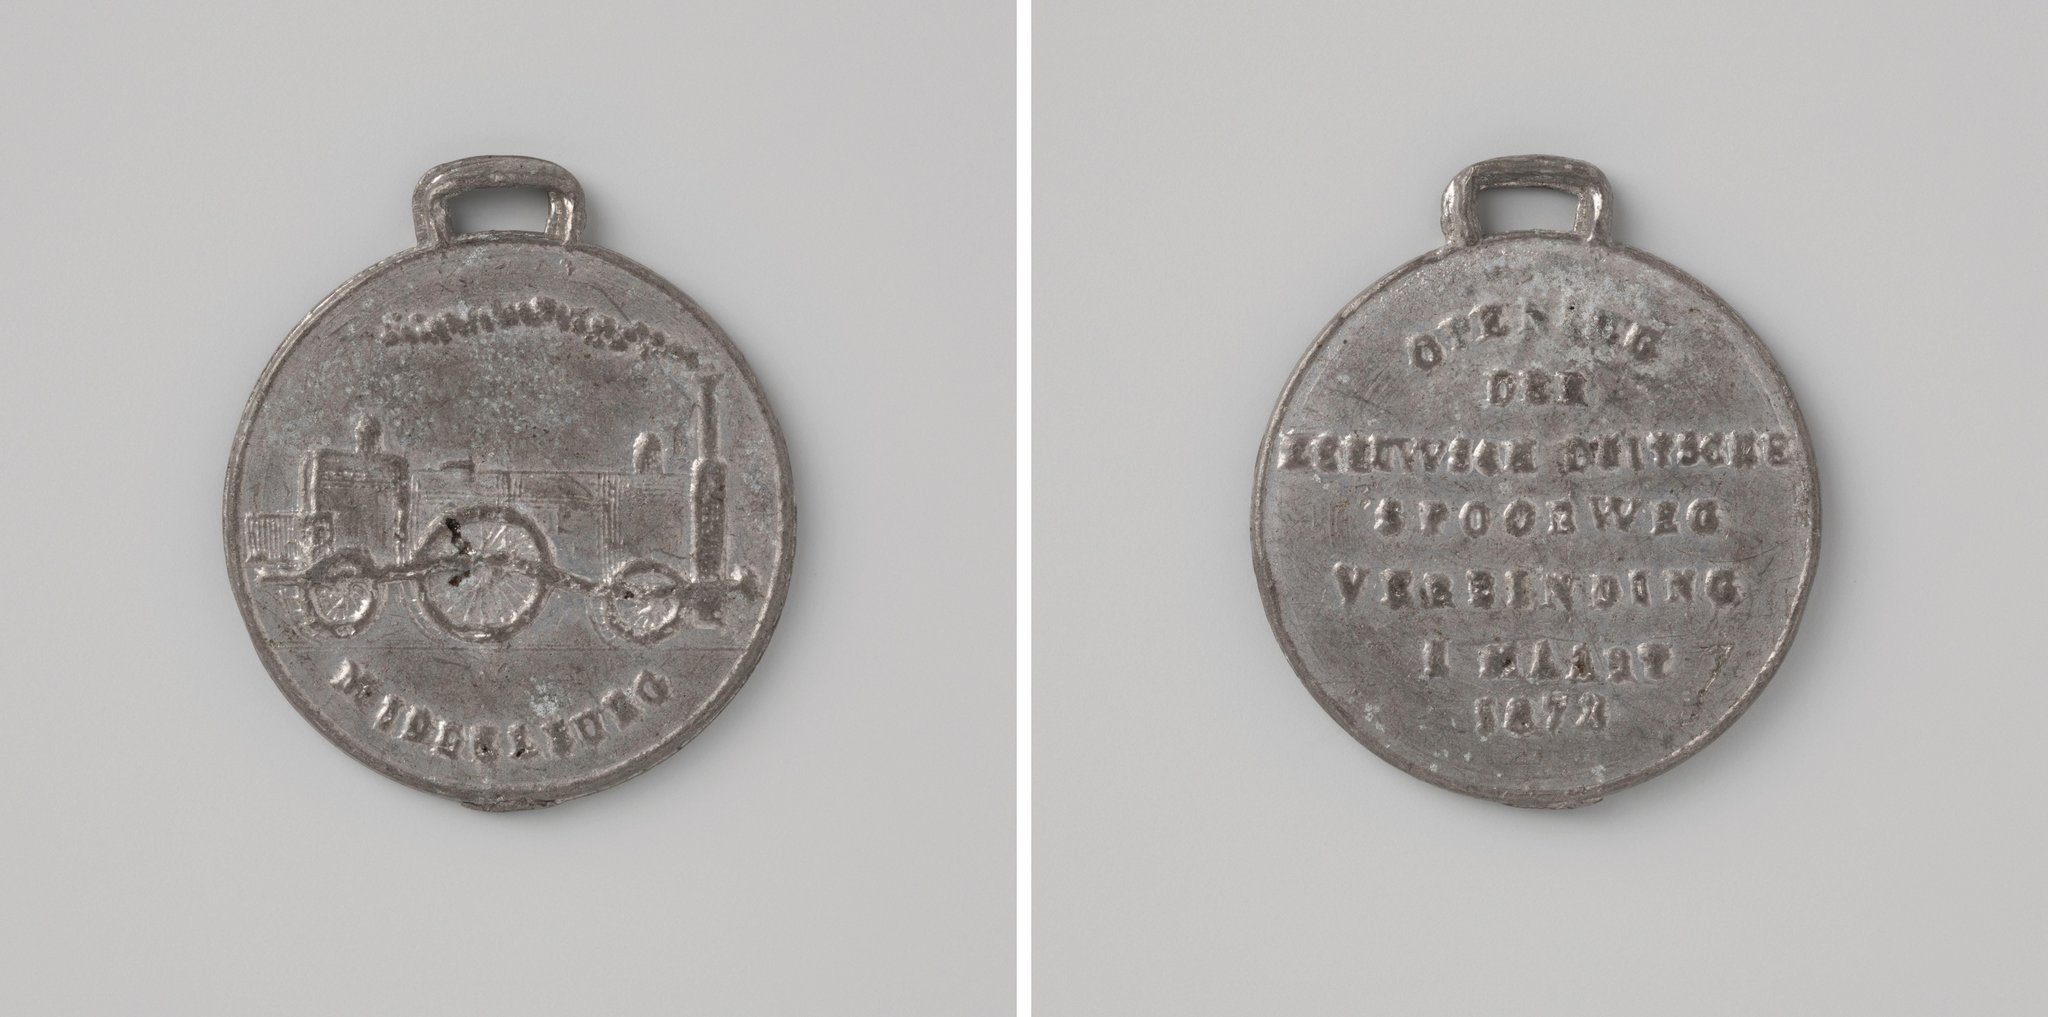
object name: insignia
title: Opening van de Zeeuws-Duitse Spoorwegverbinding 1873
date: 1873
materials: lead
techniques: casting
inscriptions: inscription: ‘OPENING / DER / ZEEUWSCHE DUITSCHE / SPOORWEG / VERBINDING / 1 MAART / 1873’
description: Loden penninkje aan breed draagoog, op de voorzijde een locomotief naar rechts waaronder MIDDELBURG, op de keerzijde zeven regels tekst.